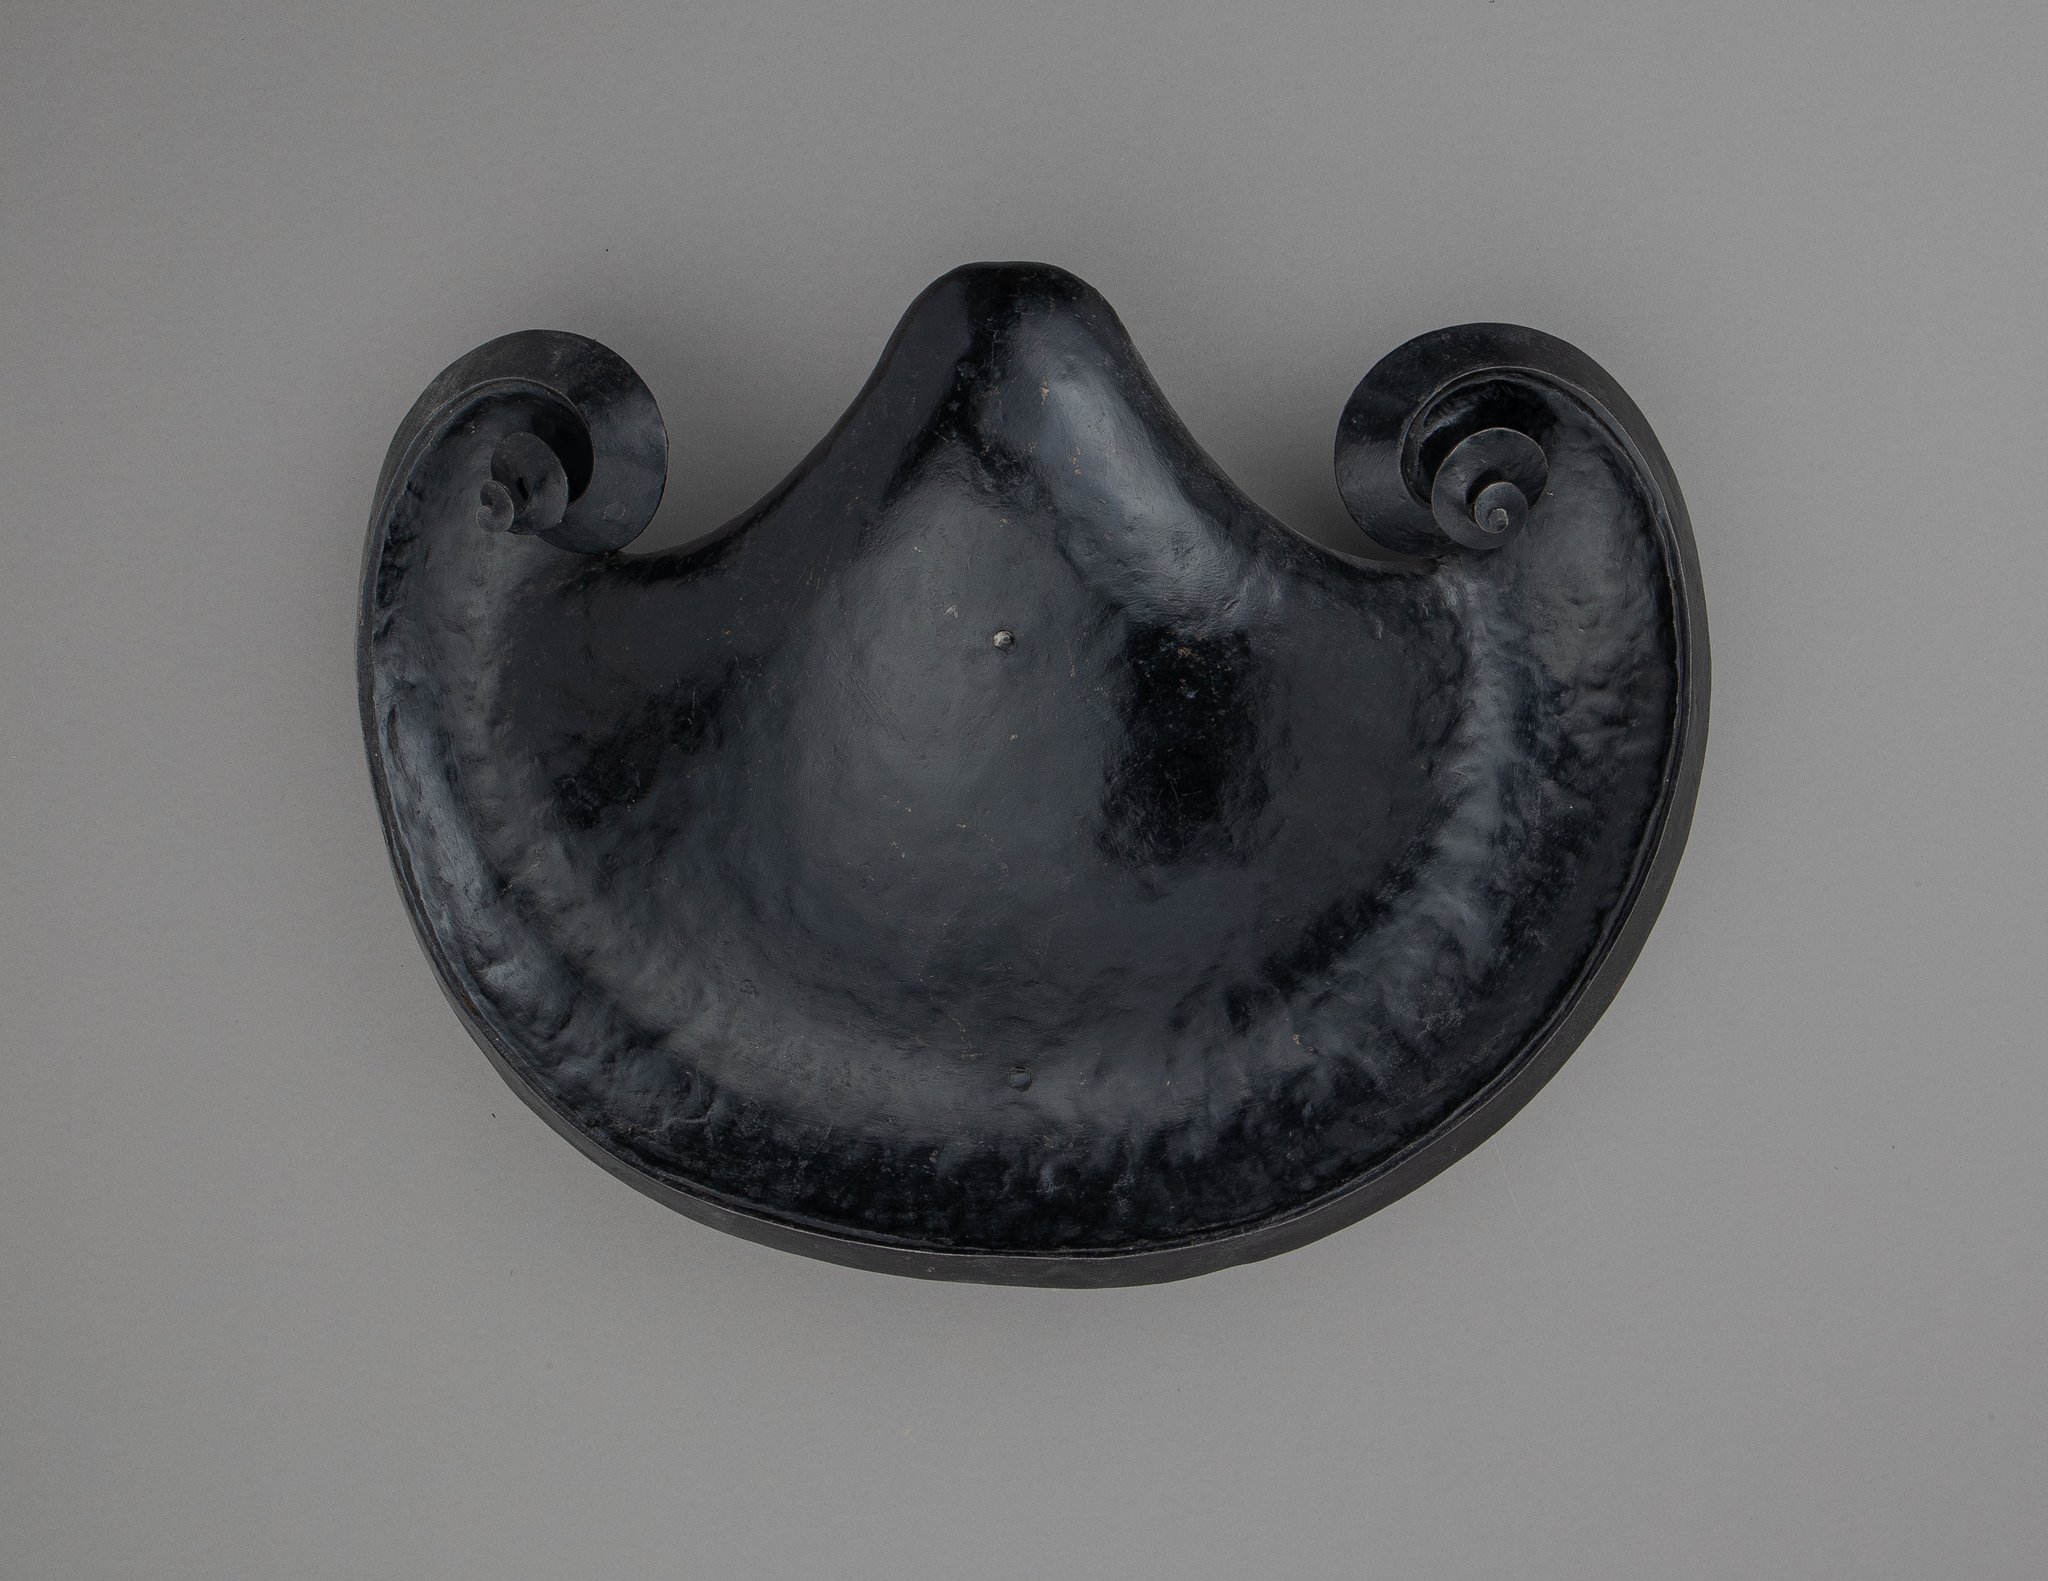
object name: shield pelta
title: Shield (Pelta)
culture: italian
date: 1501-1600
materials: leather, pigment, wood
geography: italy